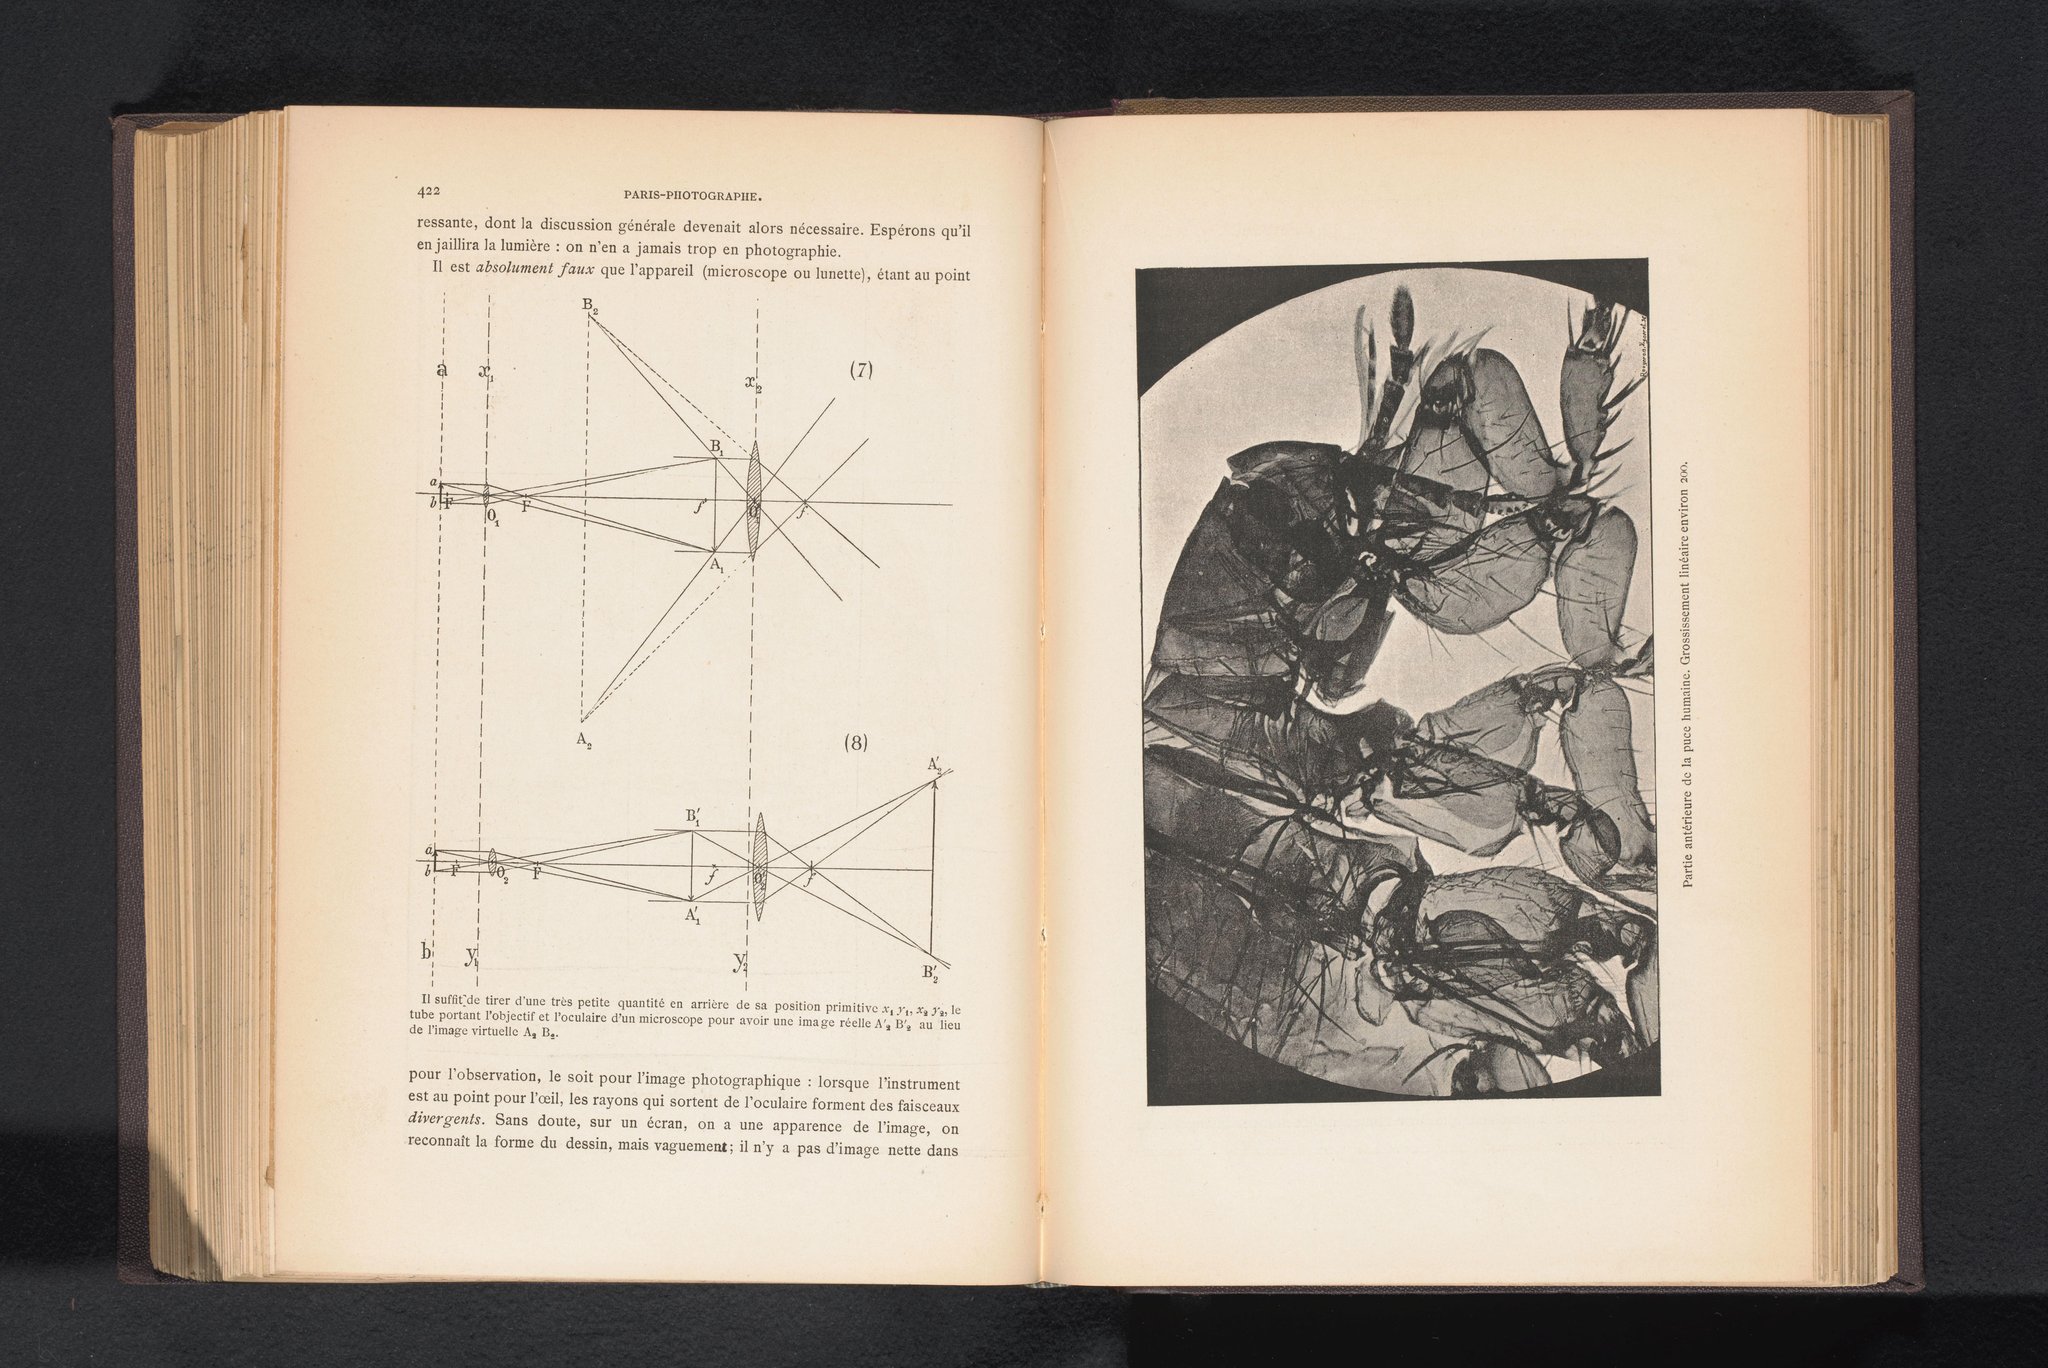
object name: page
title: Partie antérieure de la puce humaine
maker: Anonymous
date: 1882-1892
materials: paper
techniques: autotype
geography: france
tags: insects: flea, microscope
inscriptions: inscription: ‘Grossissement linéaire environ 200.’